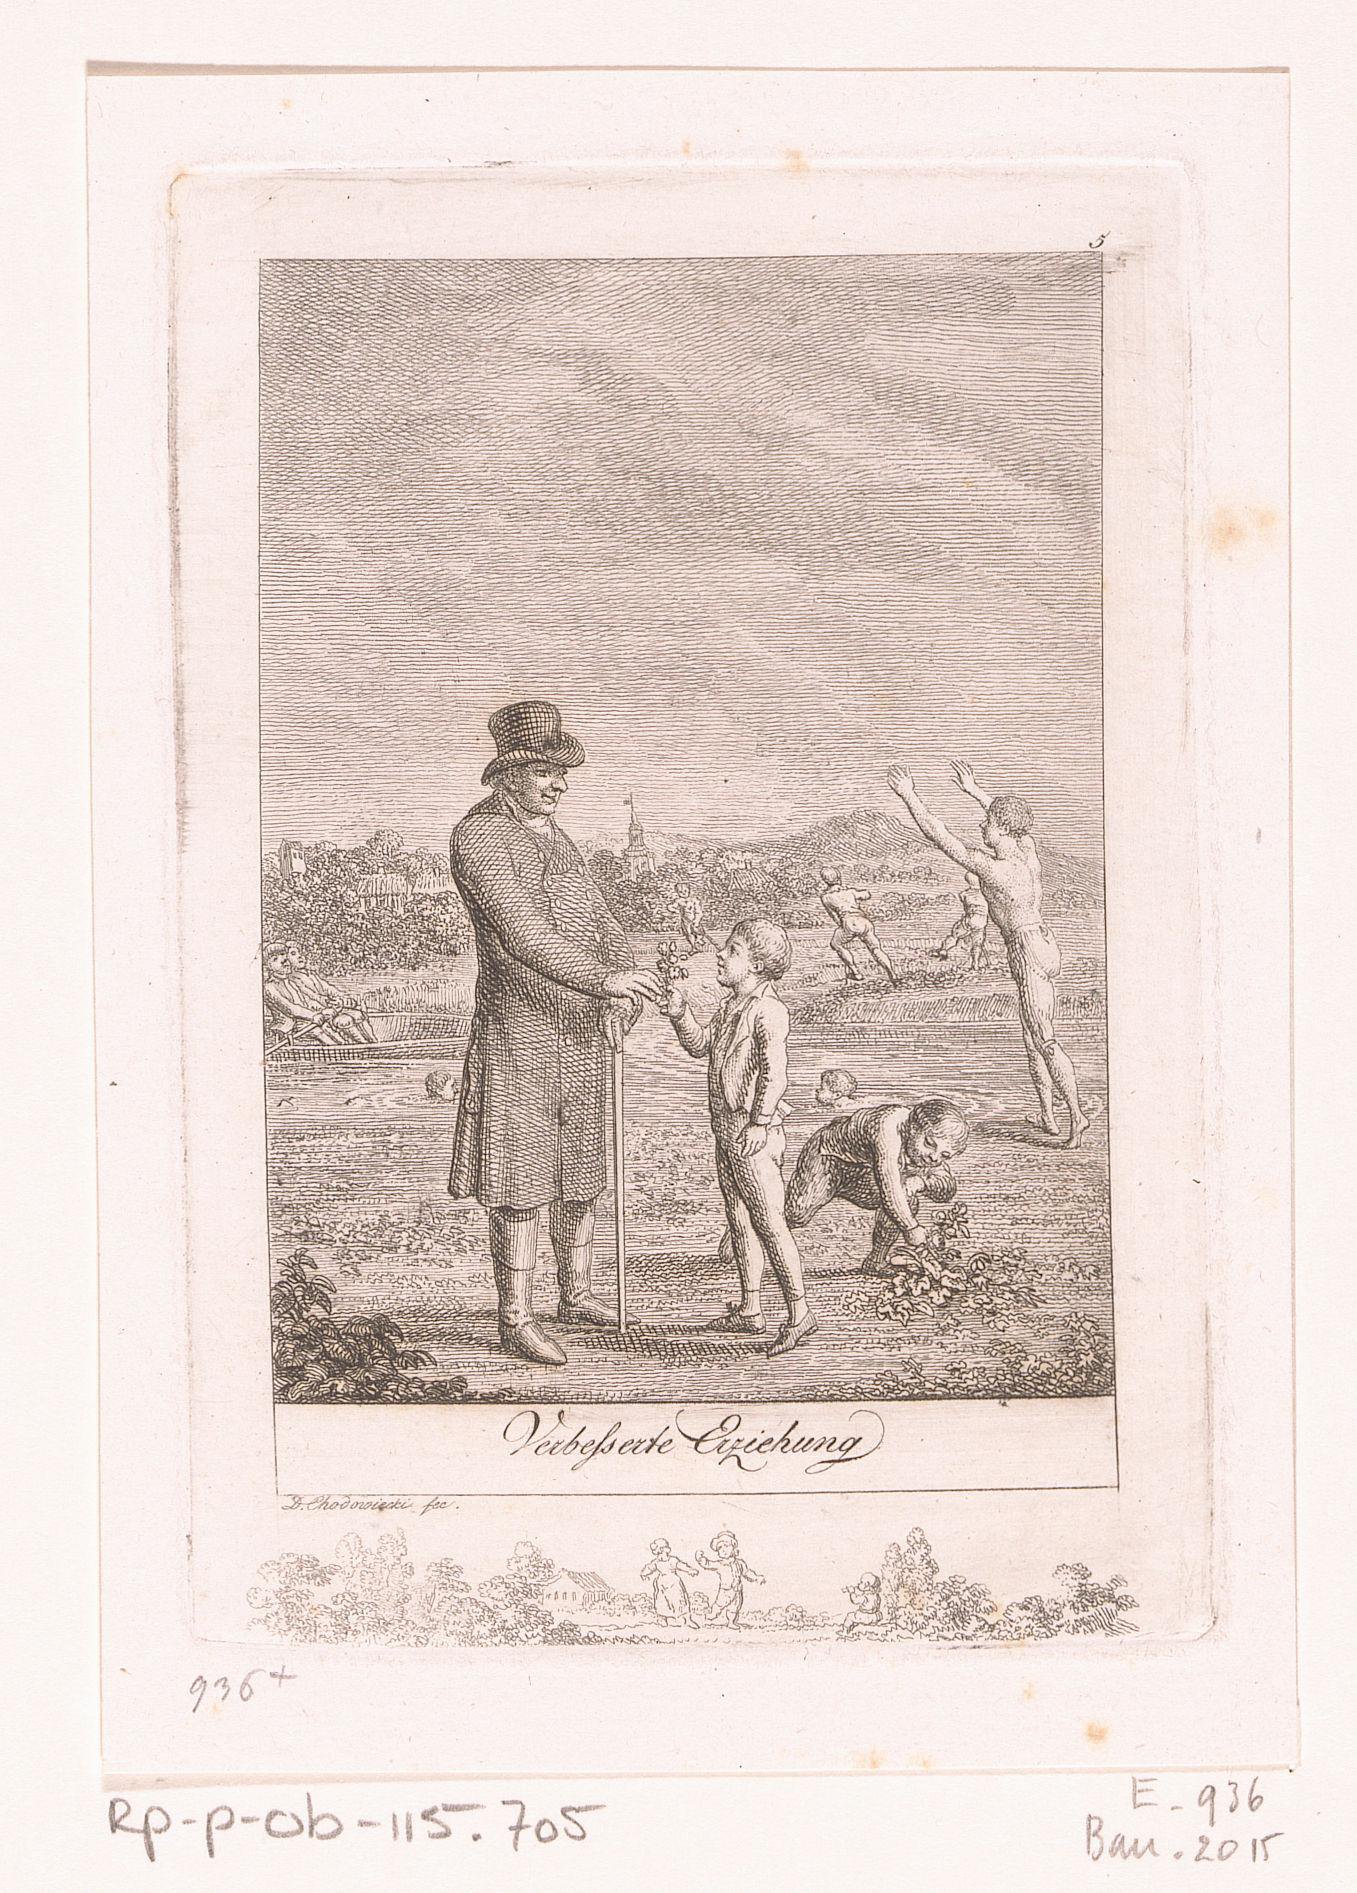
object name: print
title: Buitenspelen als goede vorm van onderwijs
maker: daniel nikolaus chodowiecki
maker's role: draughtsman, print maker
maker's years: 1726-1801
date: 1800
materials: paper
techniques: etching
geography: berlin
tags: children's games and plays (+ out of doors (sports, games, etc.))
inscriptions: collector's mark: Lugt 2228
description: Prent gebruikt voor: Salzmann, Christian Gotthilf. Taschenbuch zur Beförderung der Vaterlandsliebe. Auf das Jahr 1801 (...). Schnepfenthal: s.n., 1801.